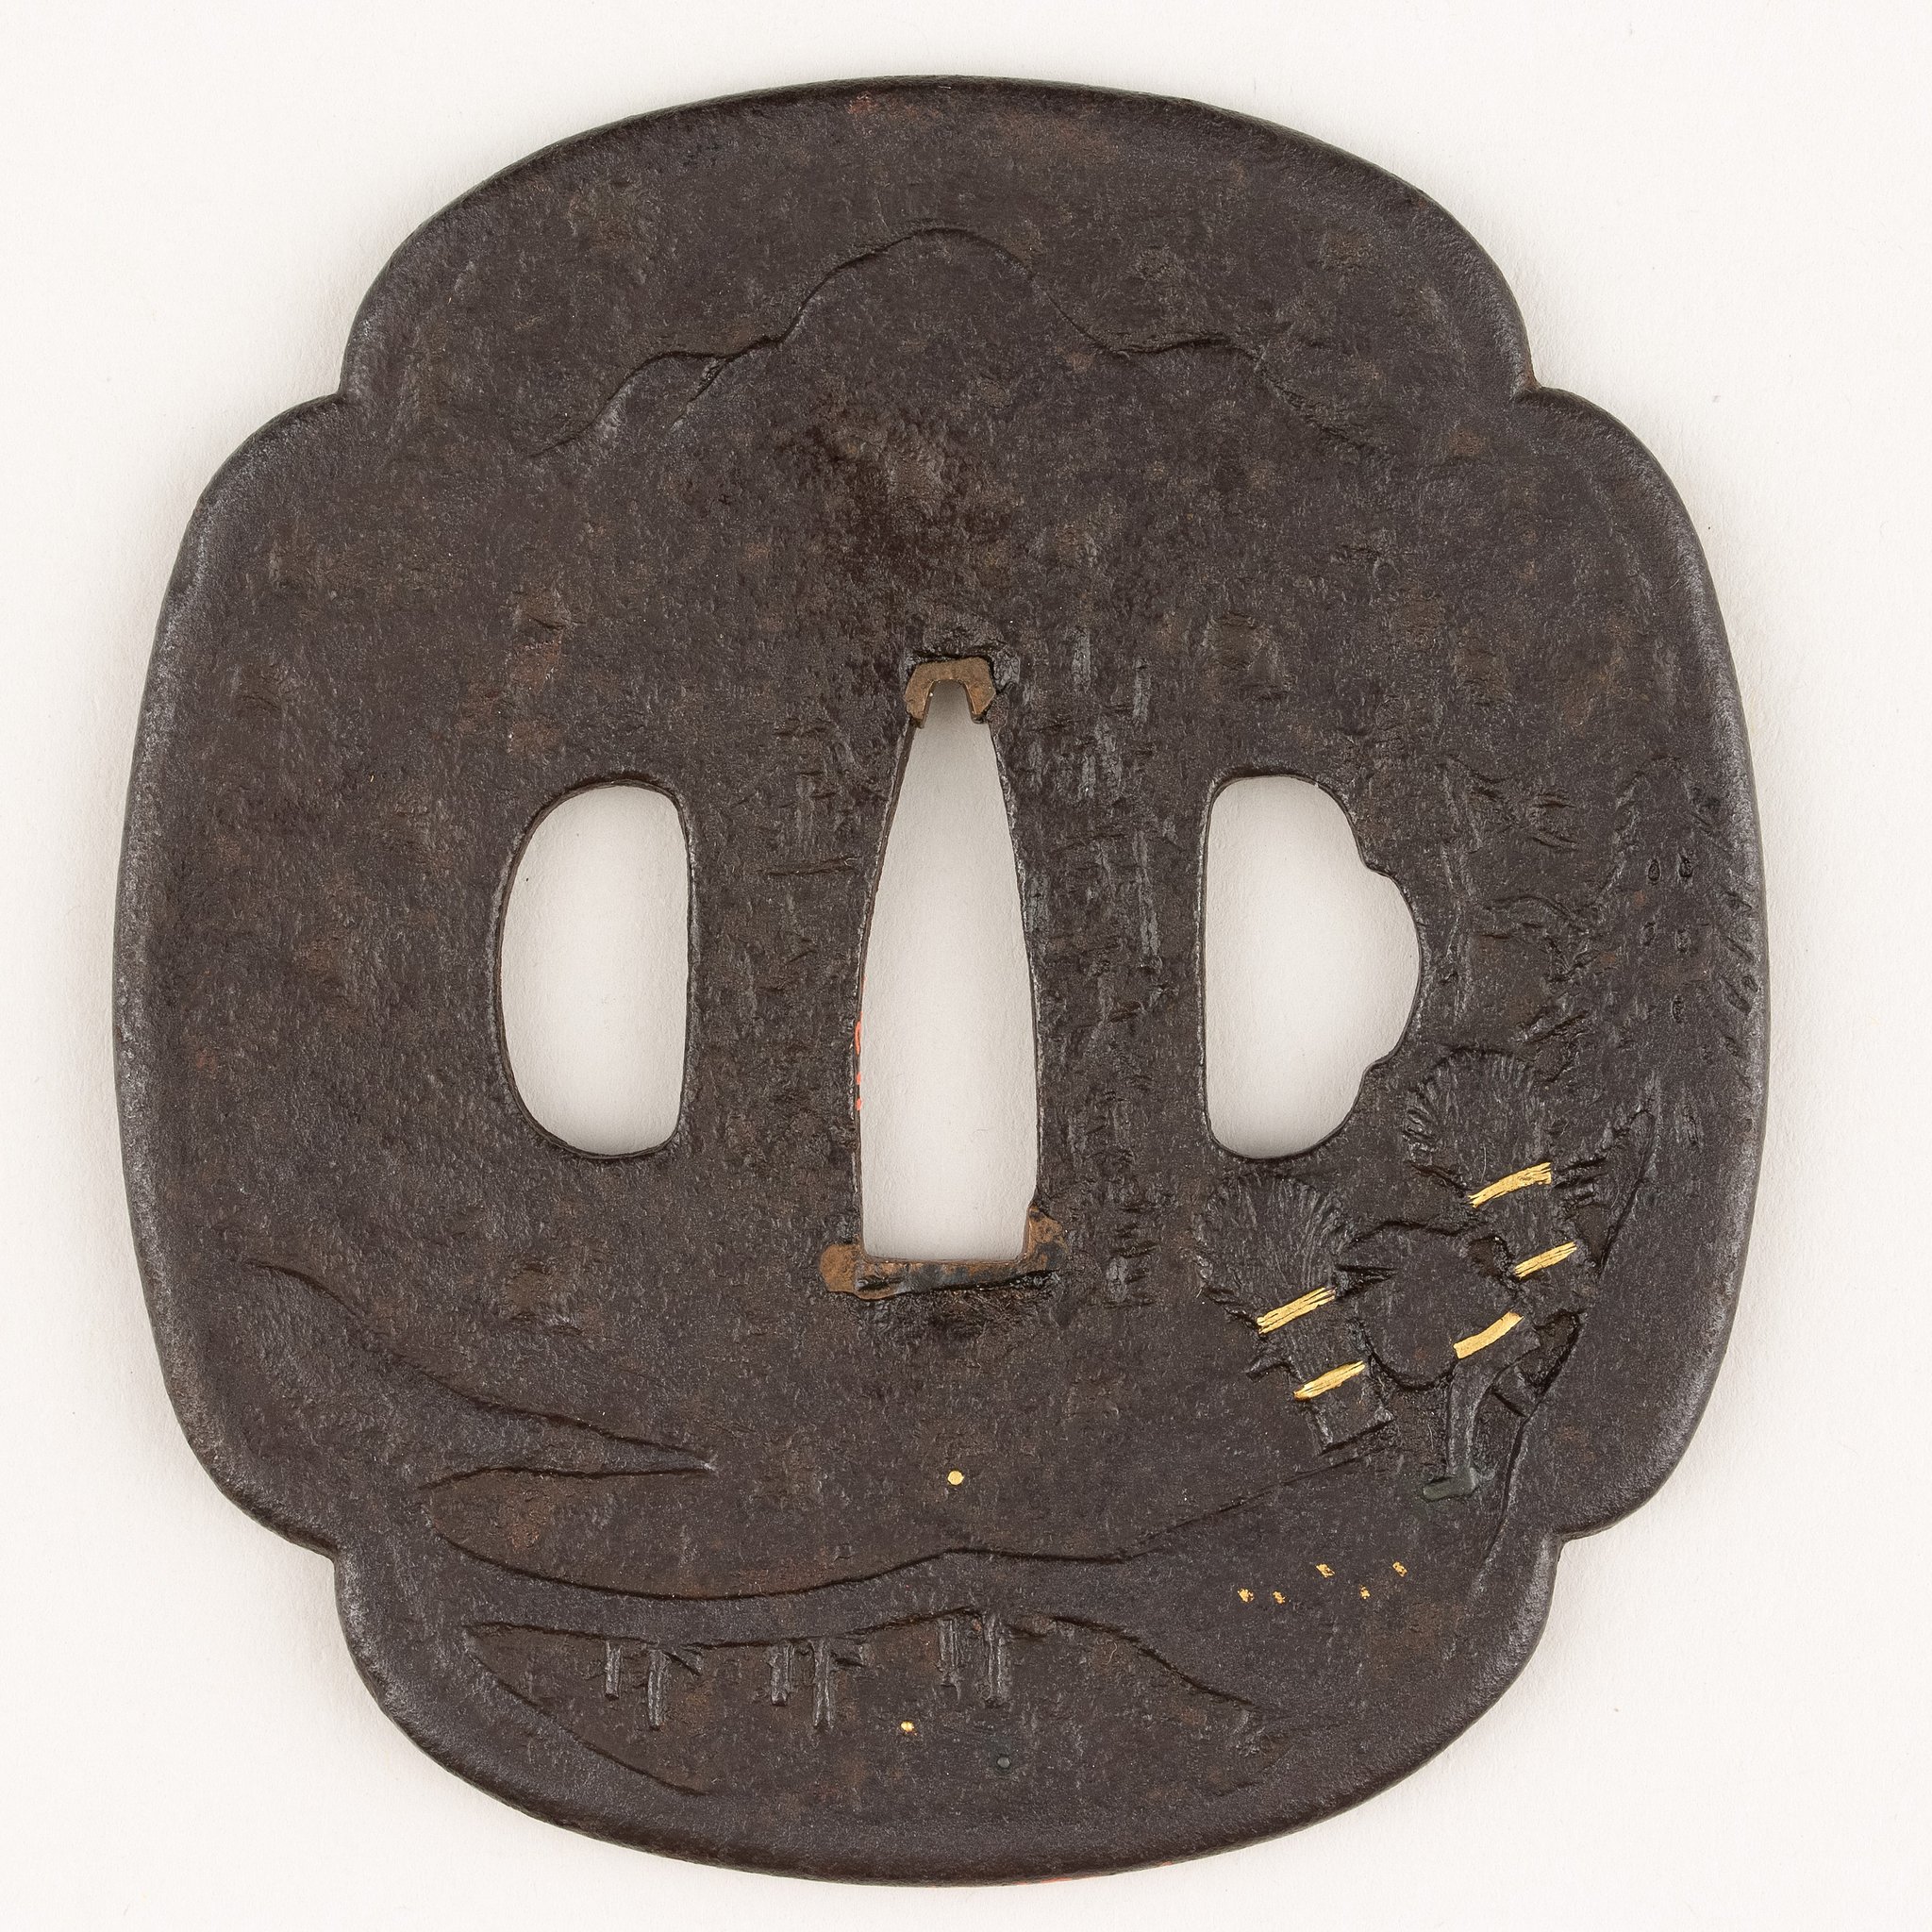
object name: sword guard tsuba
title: Sword Guard (Tsuba)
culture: japanese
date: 1600-1625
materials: gold, iron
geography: japan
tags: human figures,birds,mountains